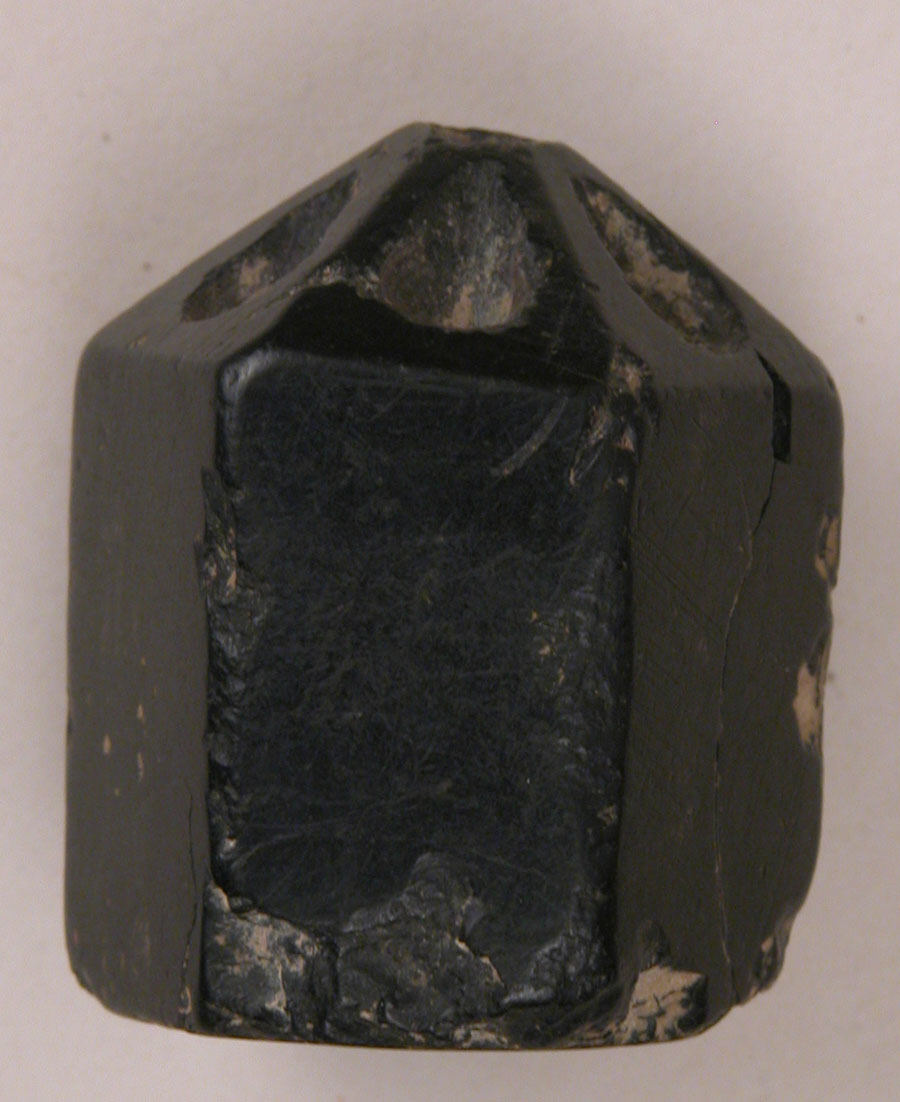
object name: chess piece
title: Chess Piece, Pawn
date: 801-1400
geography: western islamic lands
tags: chess